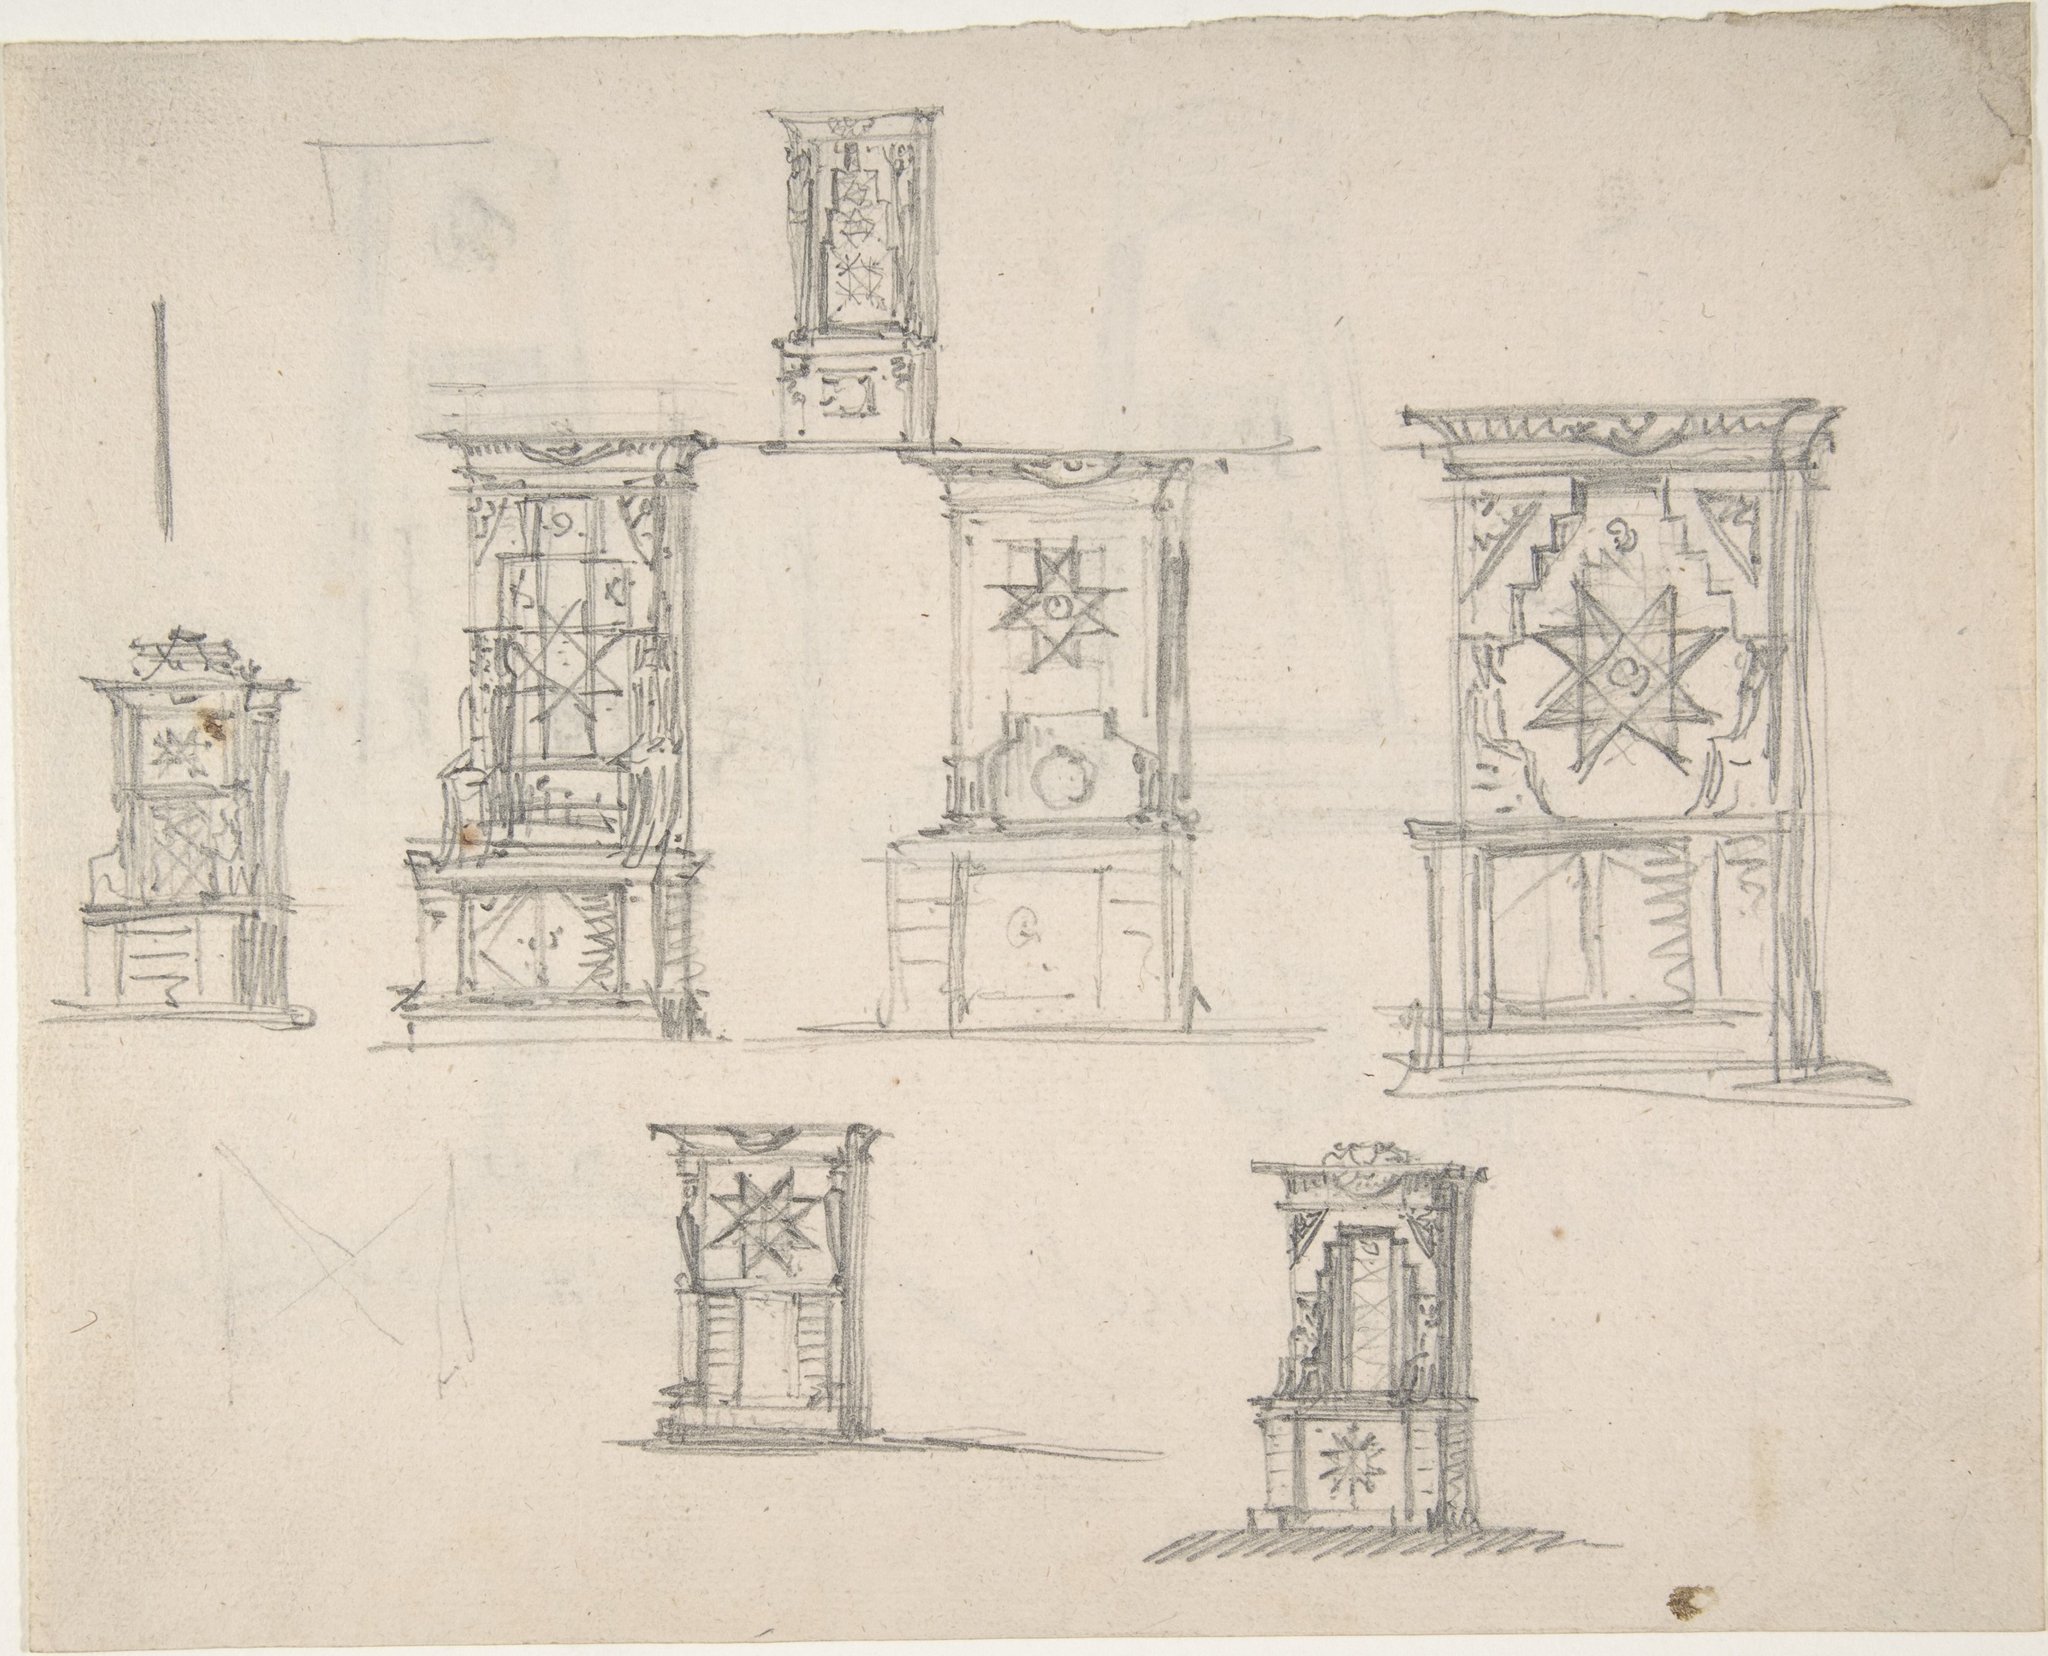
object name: drawing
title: Design studies for monuments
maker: anonymous, german, 19th century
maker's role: artist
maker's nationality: german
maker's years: 1800-1899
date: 1801-1900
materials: graphite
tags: monuments